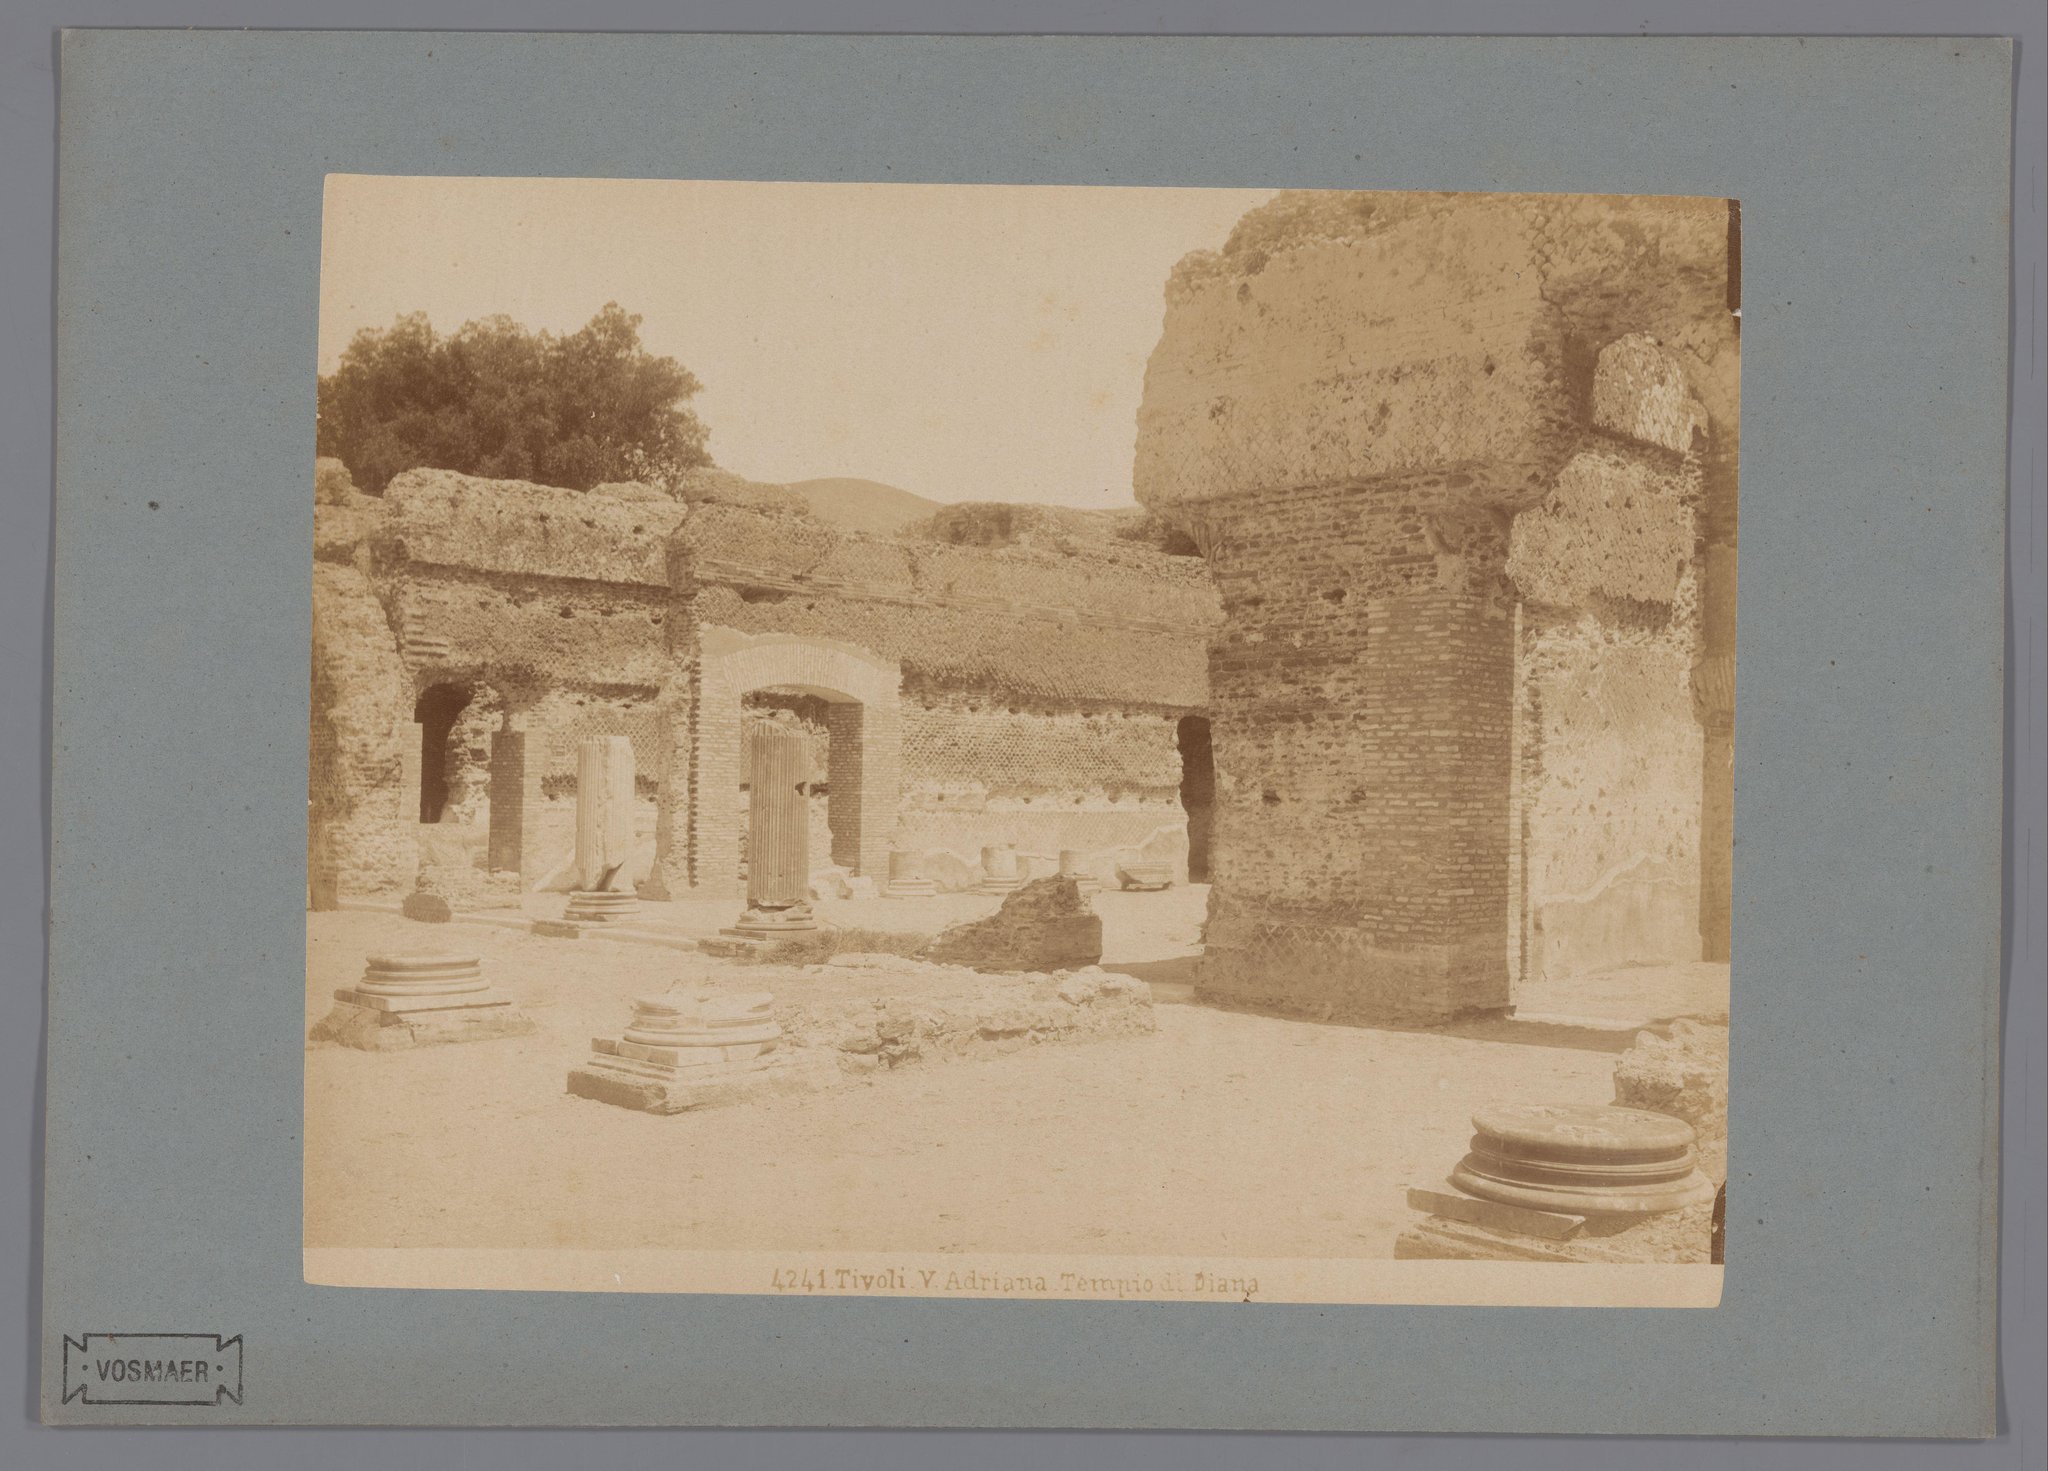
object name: photograph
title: Tivoli. V. Adriana. Tempio di Diana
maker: Anonymous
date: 1851-1900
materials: cardboard, paper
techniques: albumen print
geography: tivoli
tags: ruin of a building ~ architecture, rural housing, e.g. country-house, villa, cottage, places and objects of worship ~ non-christian religions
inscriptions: number: ‘4241.’, collector's mark: ‘VOSMAER’